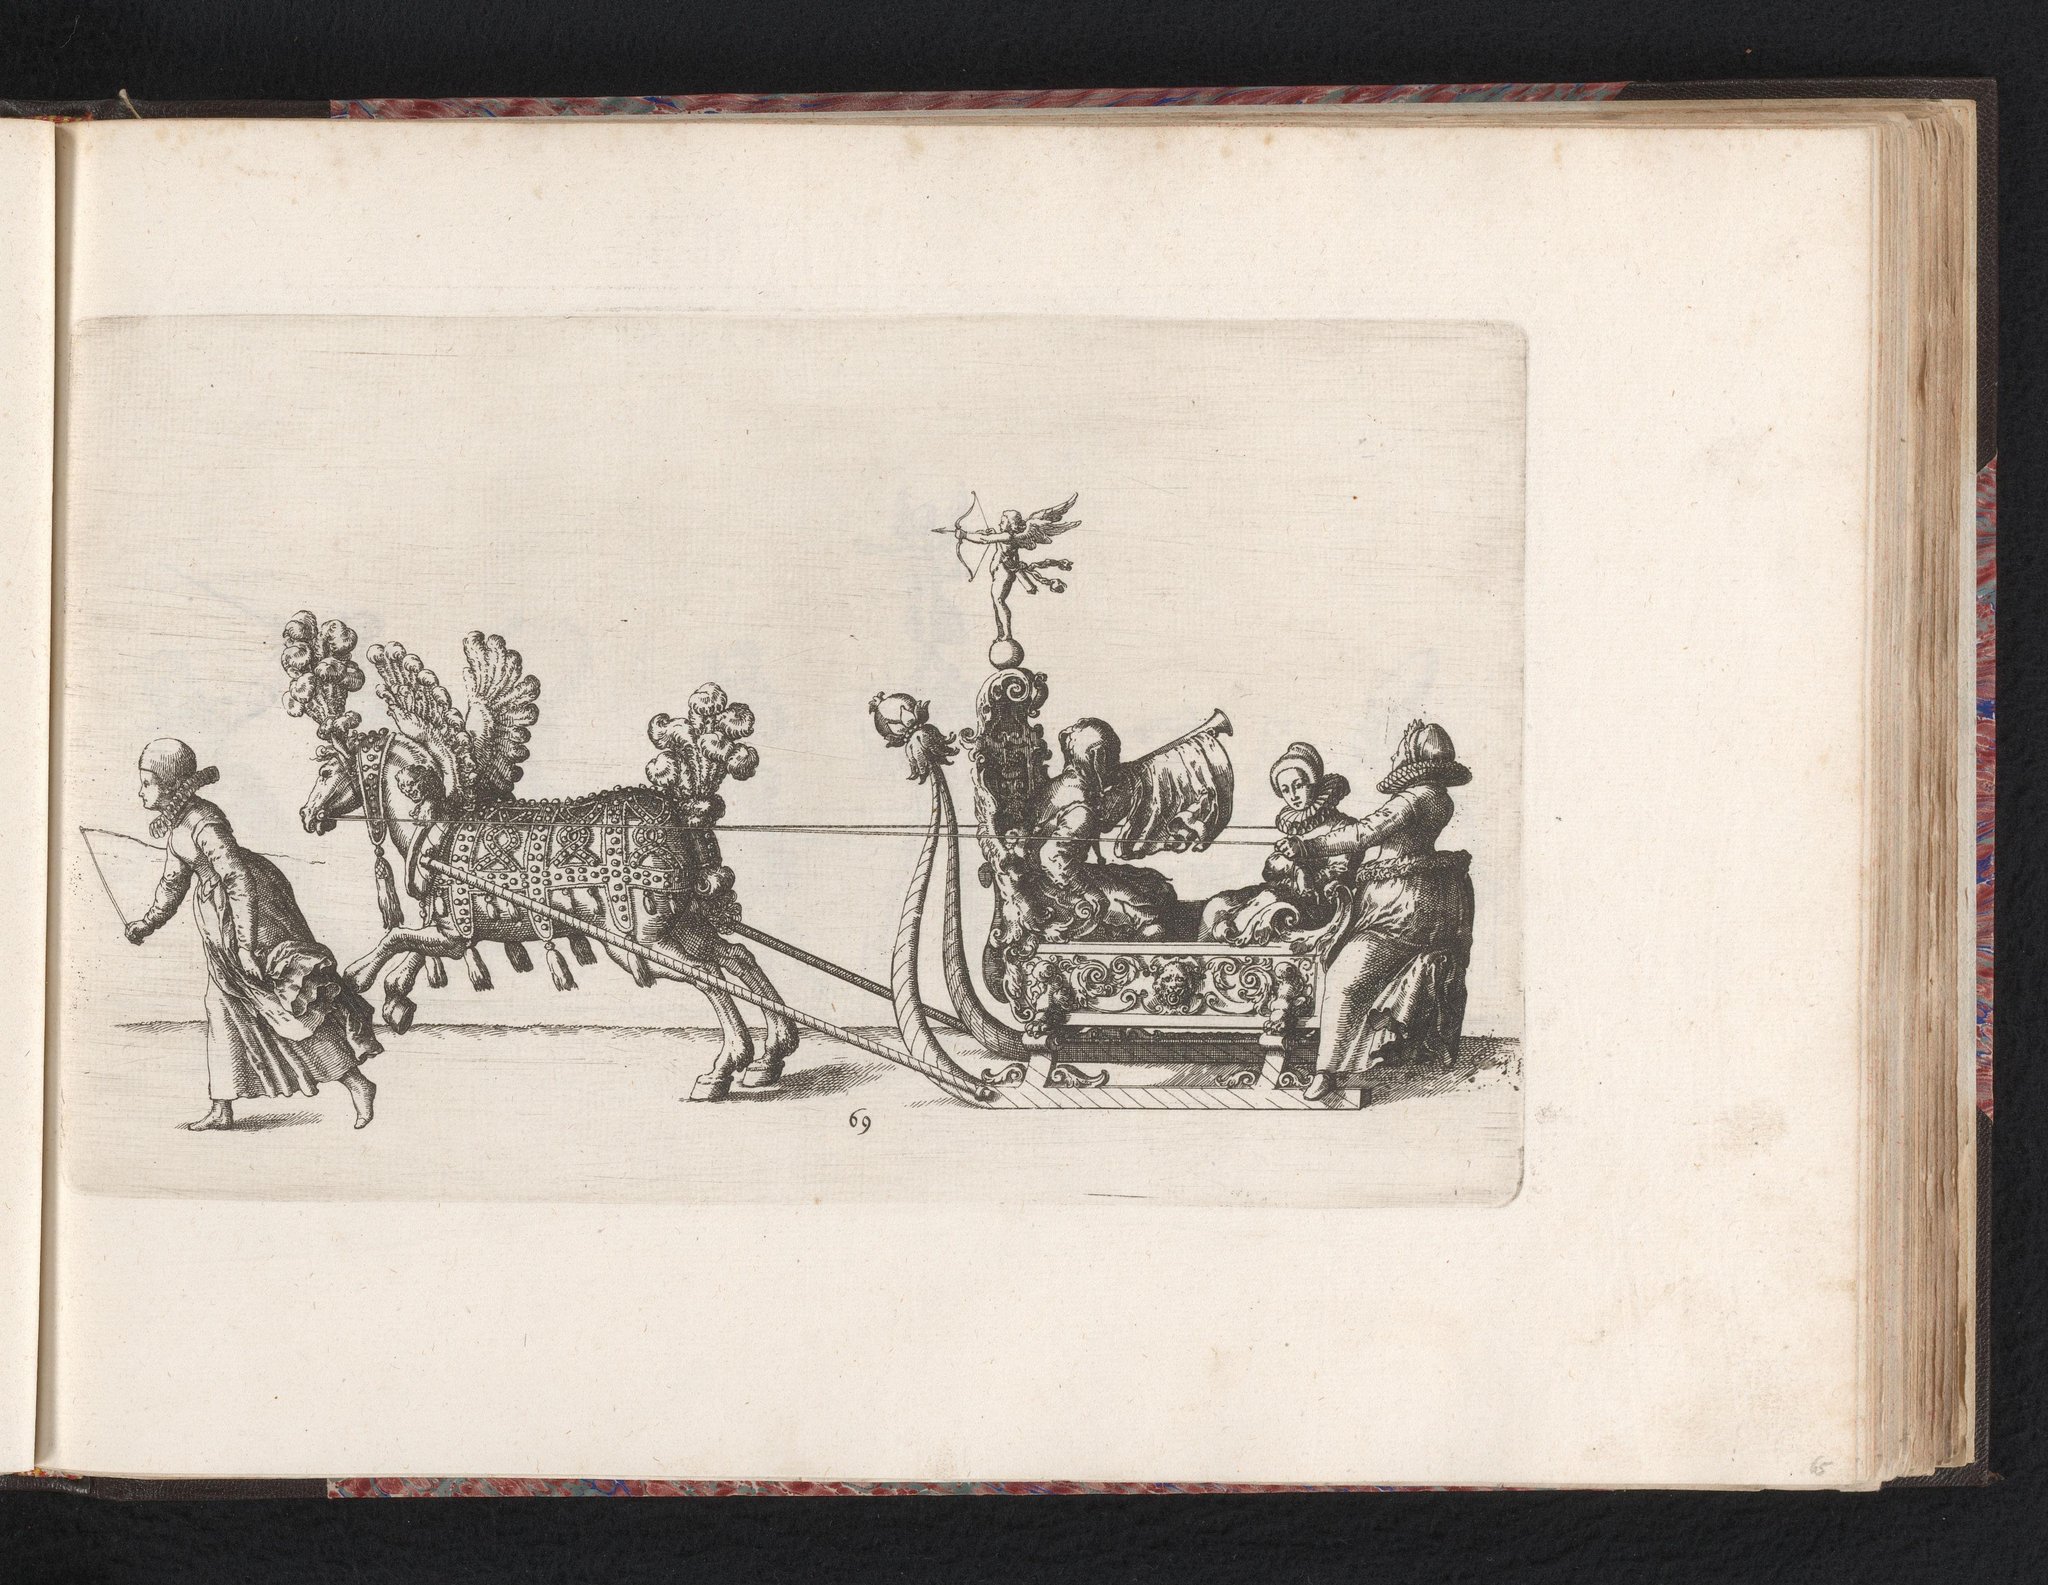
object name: album leaf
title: Optochten en ruiterspelen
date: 1618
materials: paper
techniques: etching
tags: court jester, court fool, horse-sleigh, performance in the open air (pleasure fair), fabulous animals ~ hoofed animals: winged horse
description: Genummerd: 69. Deze prent maakt deel uit van een album.